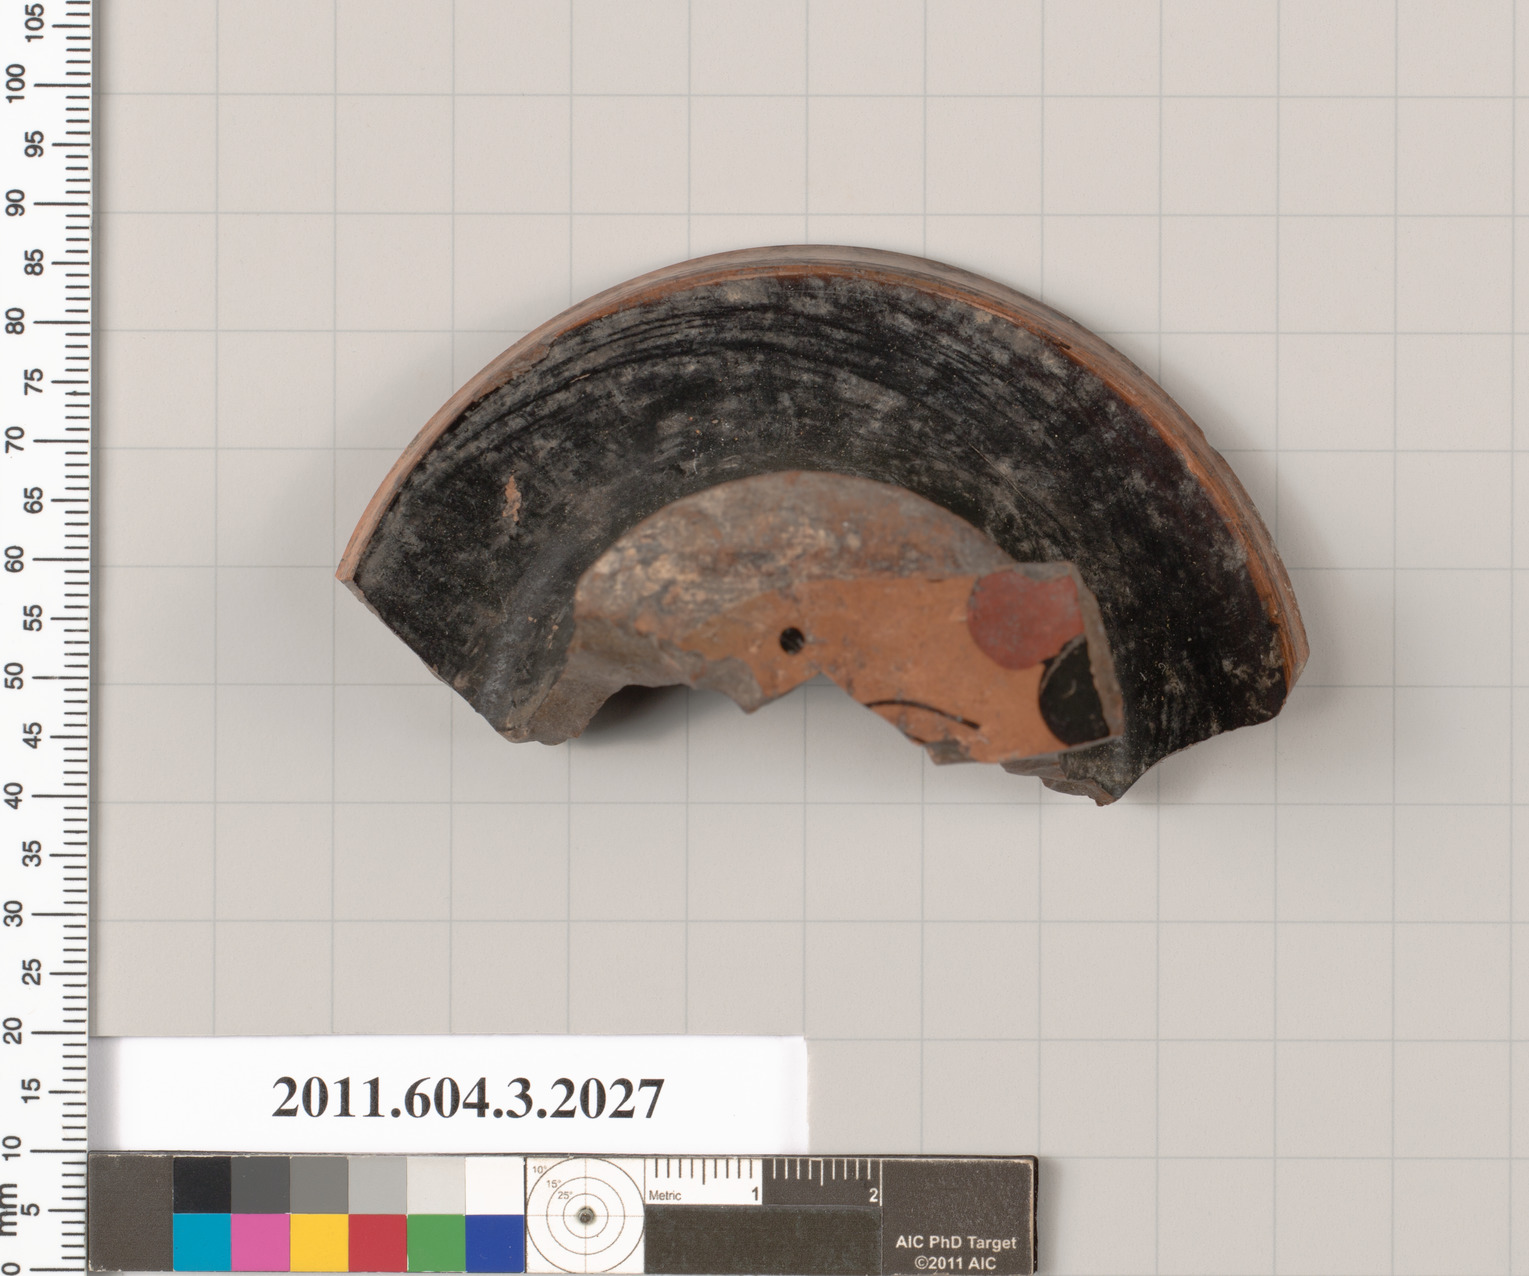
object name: kylix fragment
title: Terracotta fragment of a kylix (drinking cup)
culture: greek, attic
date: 550-526 BCE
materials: terracotta